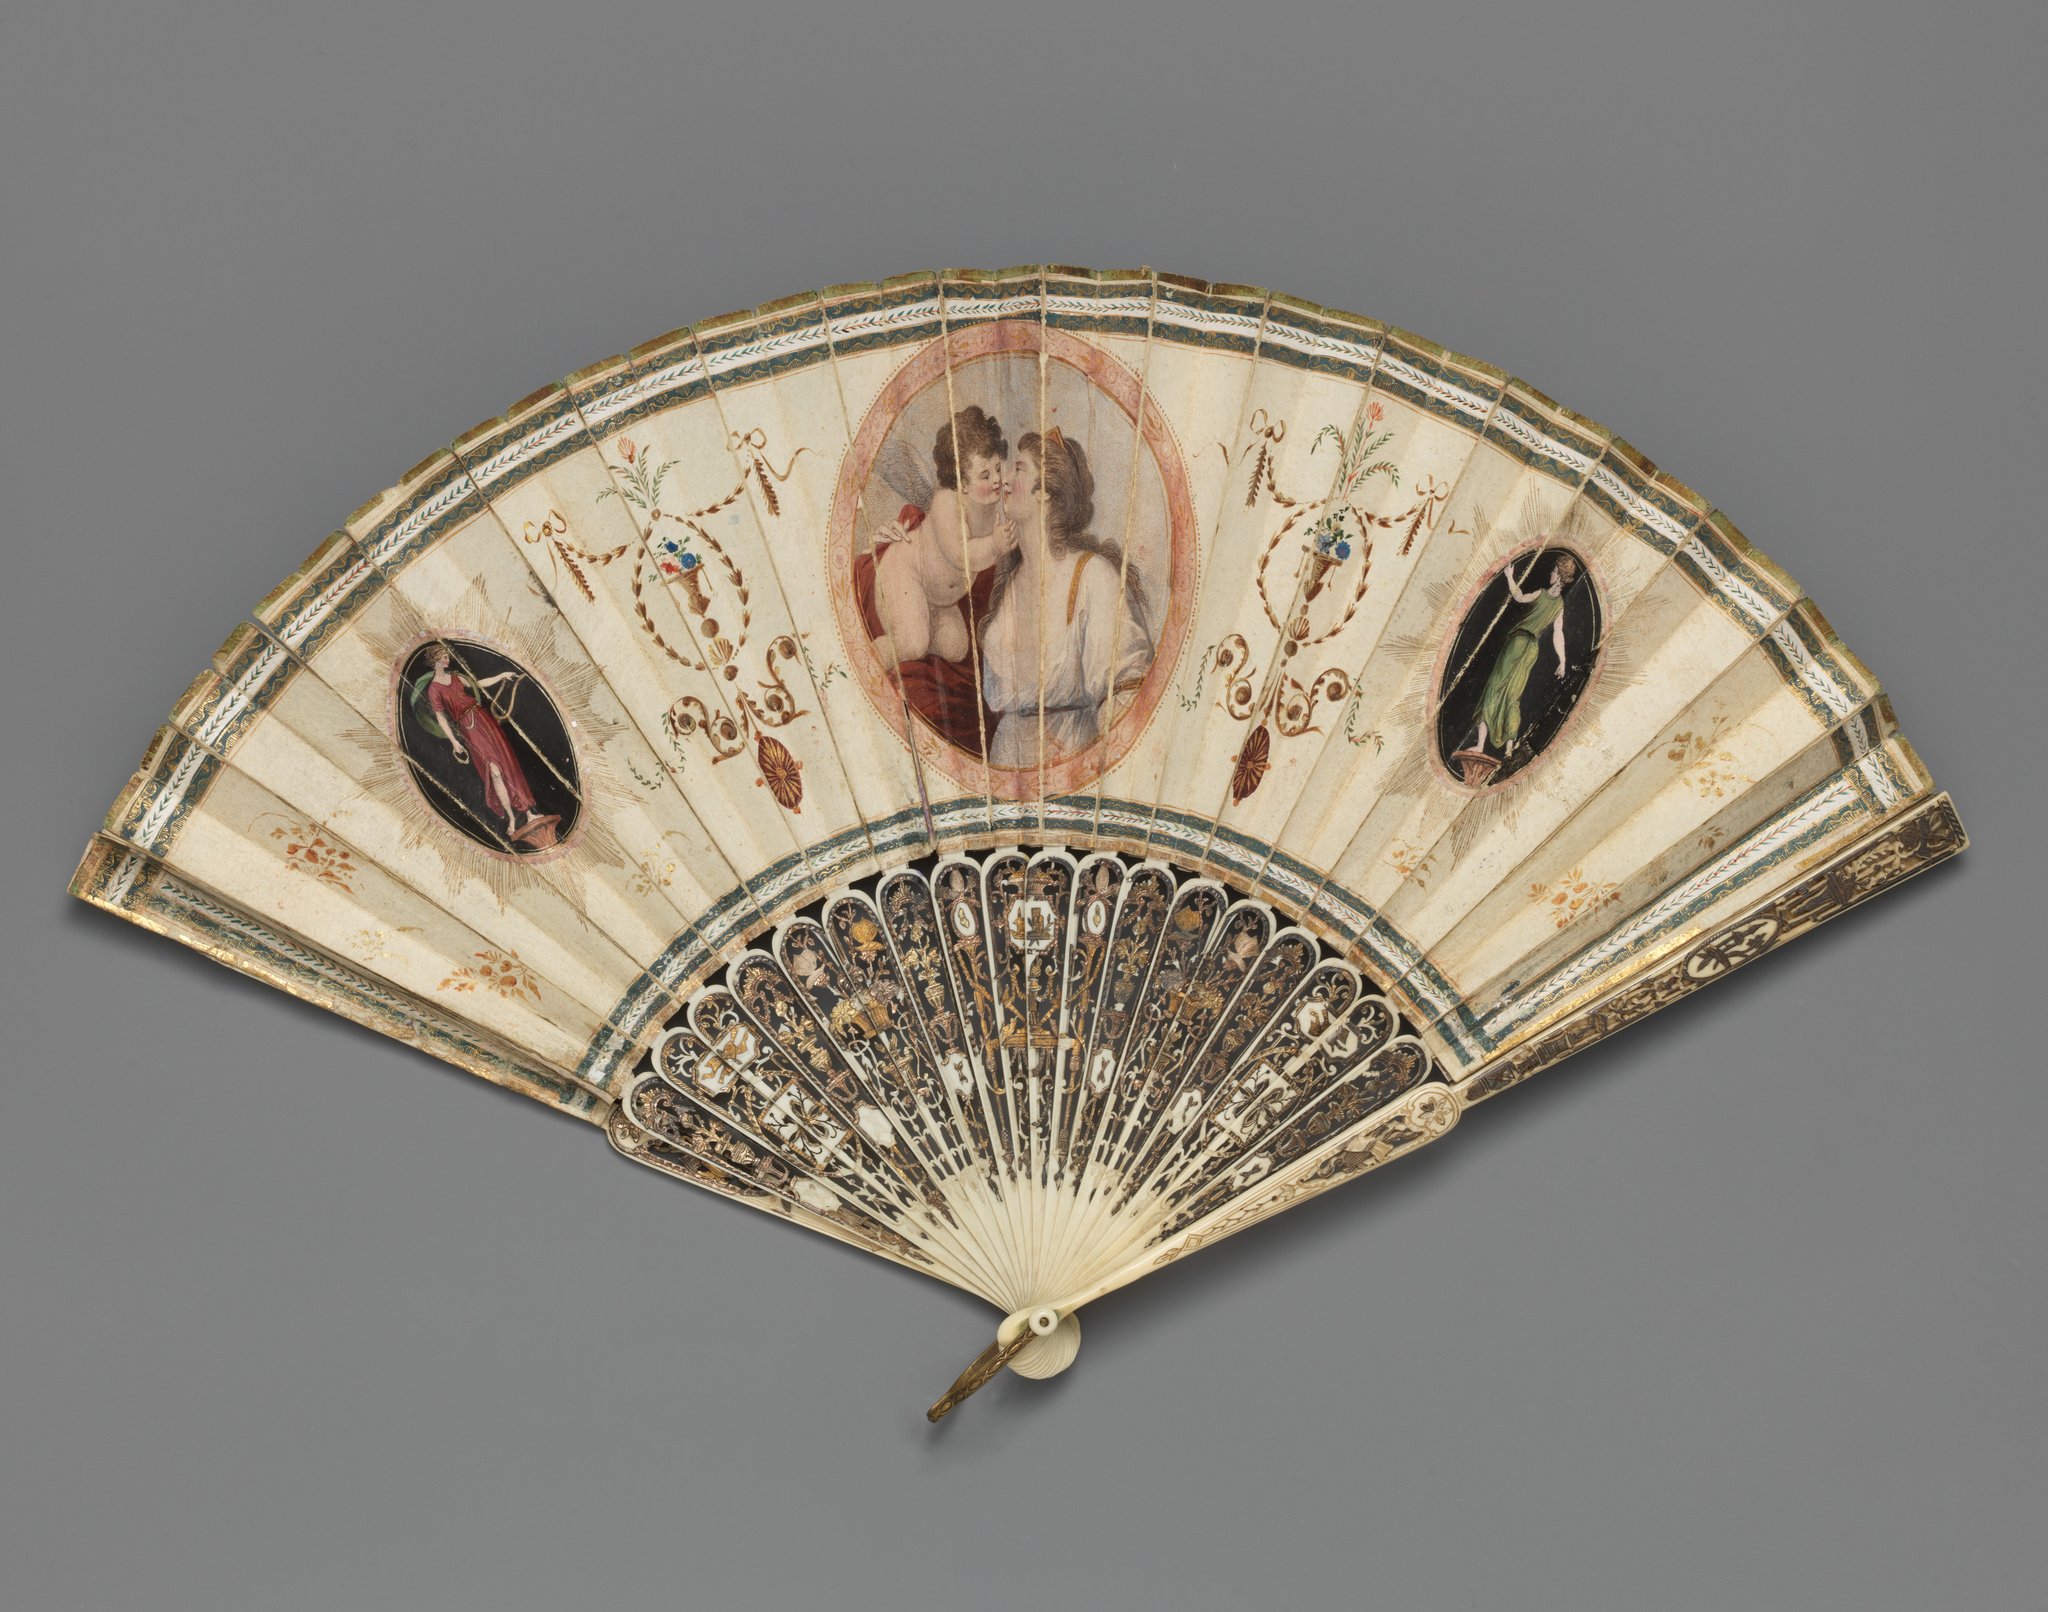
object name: fan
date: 1767-1800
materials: ivory, paper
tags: women,cupid